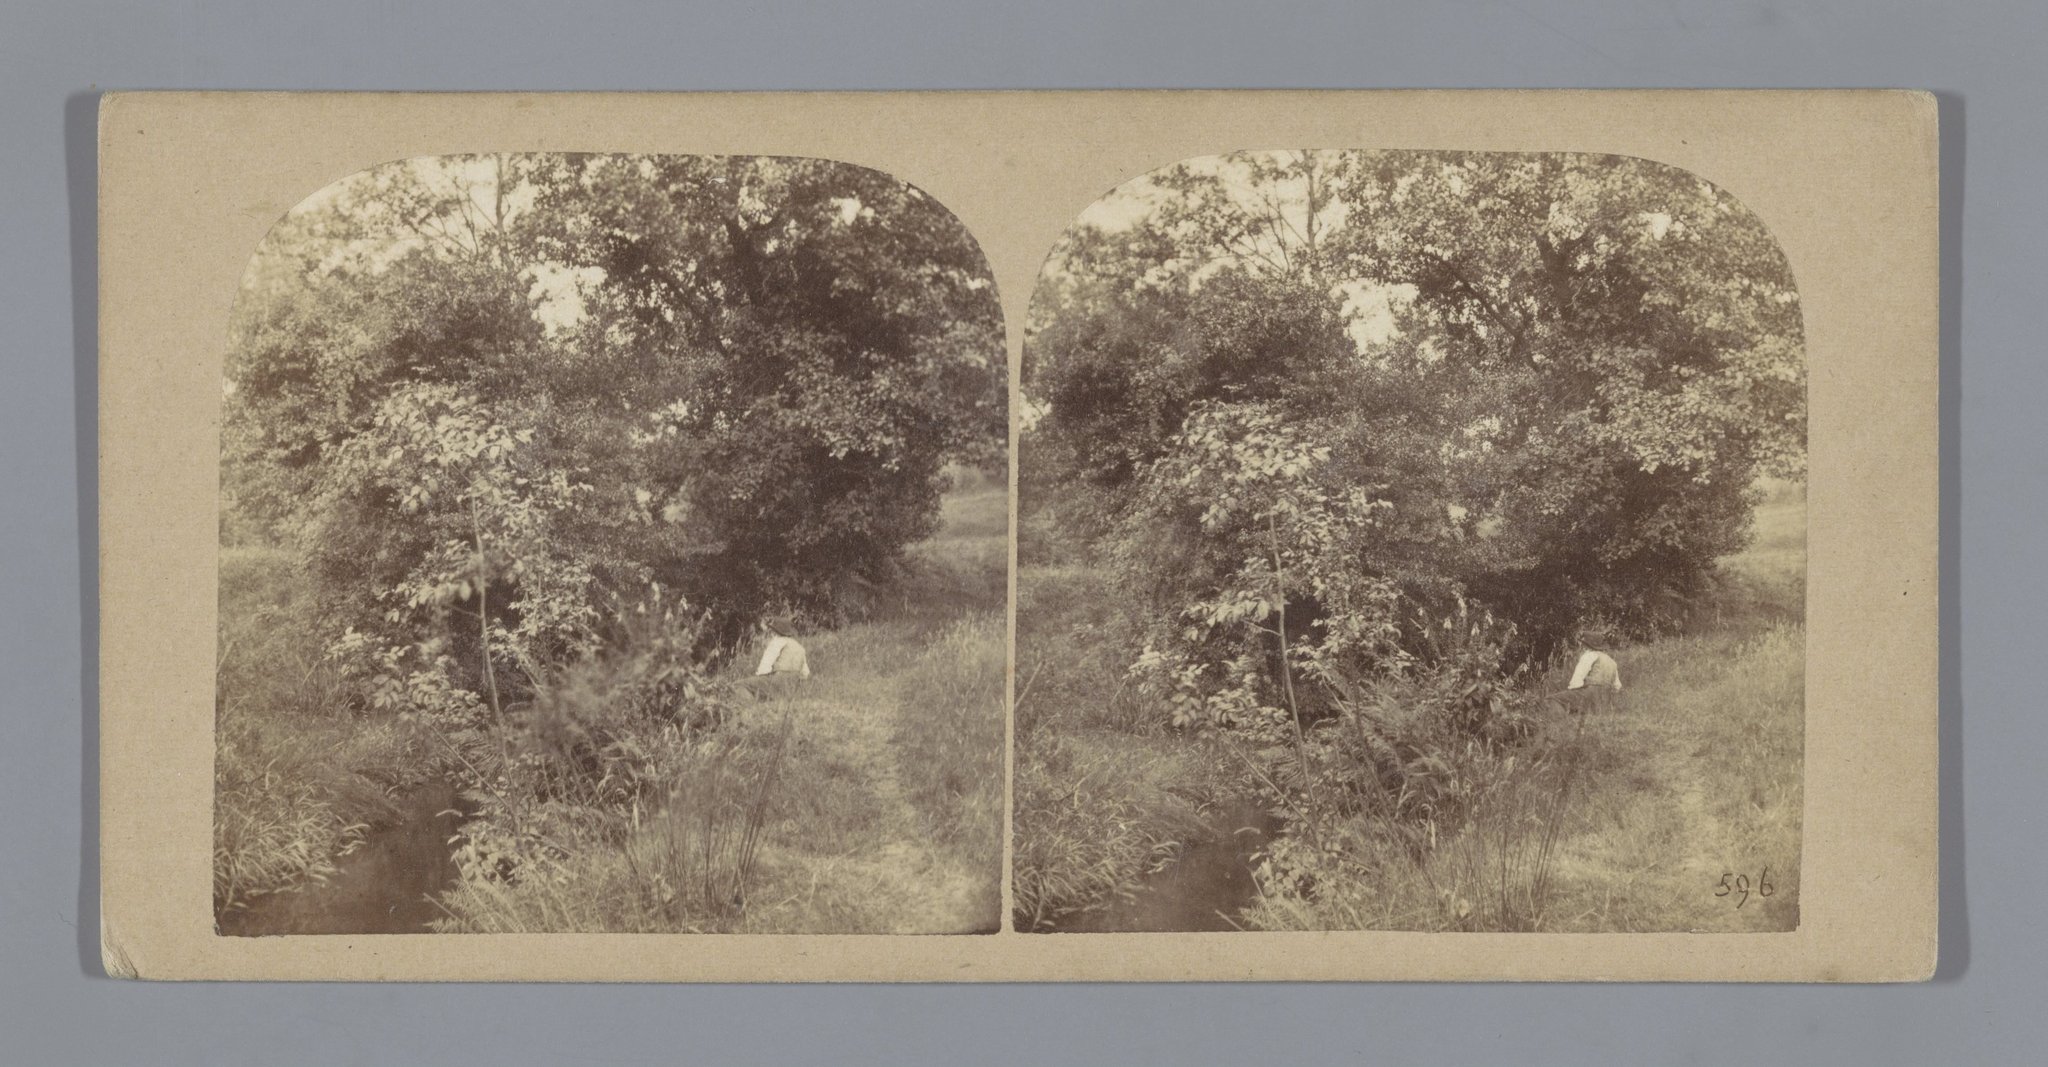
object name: stereograph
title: Landschap met een figuur in de slootkant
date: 1850-1880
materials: cardboard, photographic support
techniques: albumen print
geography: sutton coldfield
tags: bush, shrubs ~ forest, small canal, ditch, europe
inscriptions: name: ‘A. Jager, Water 110, Amsterdam’, number: ‘596’